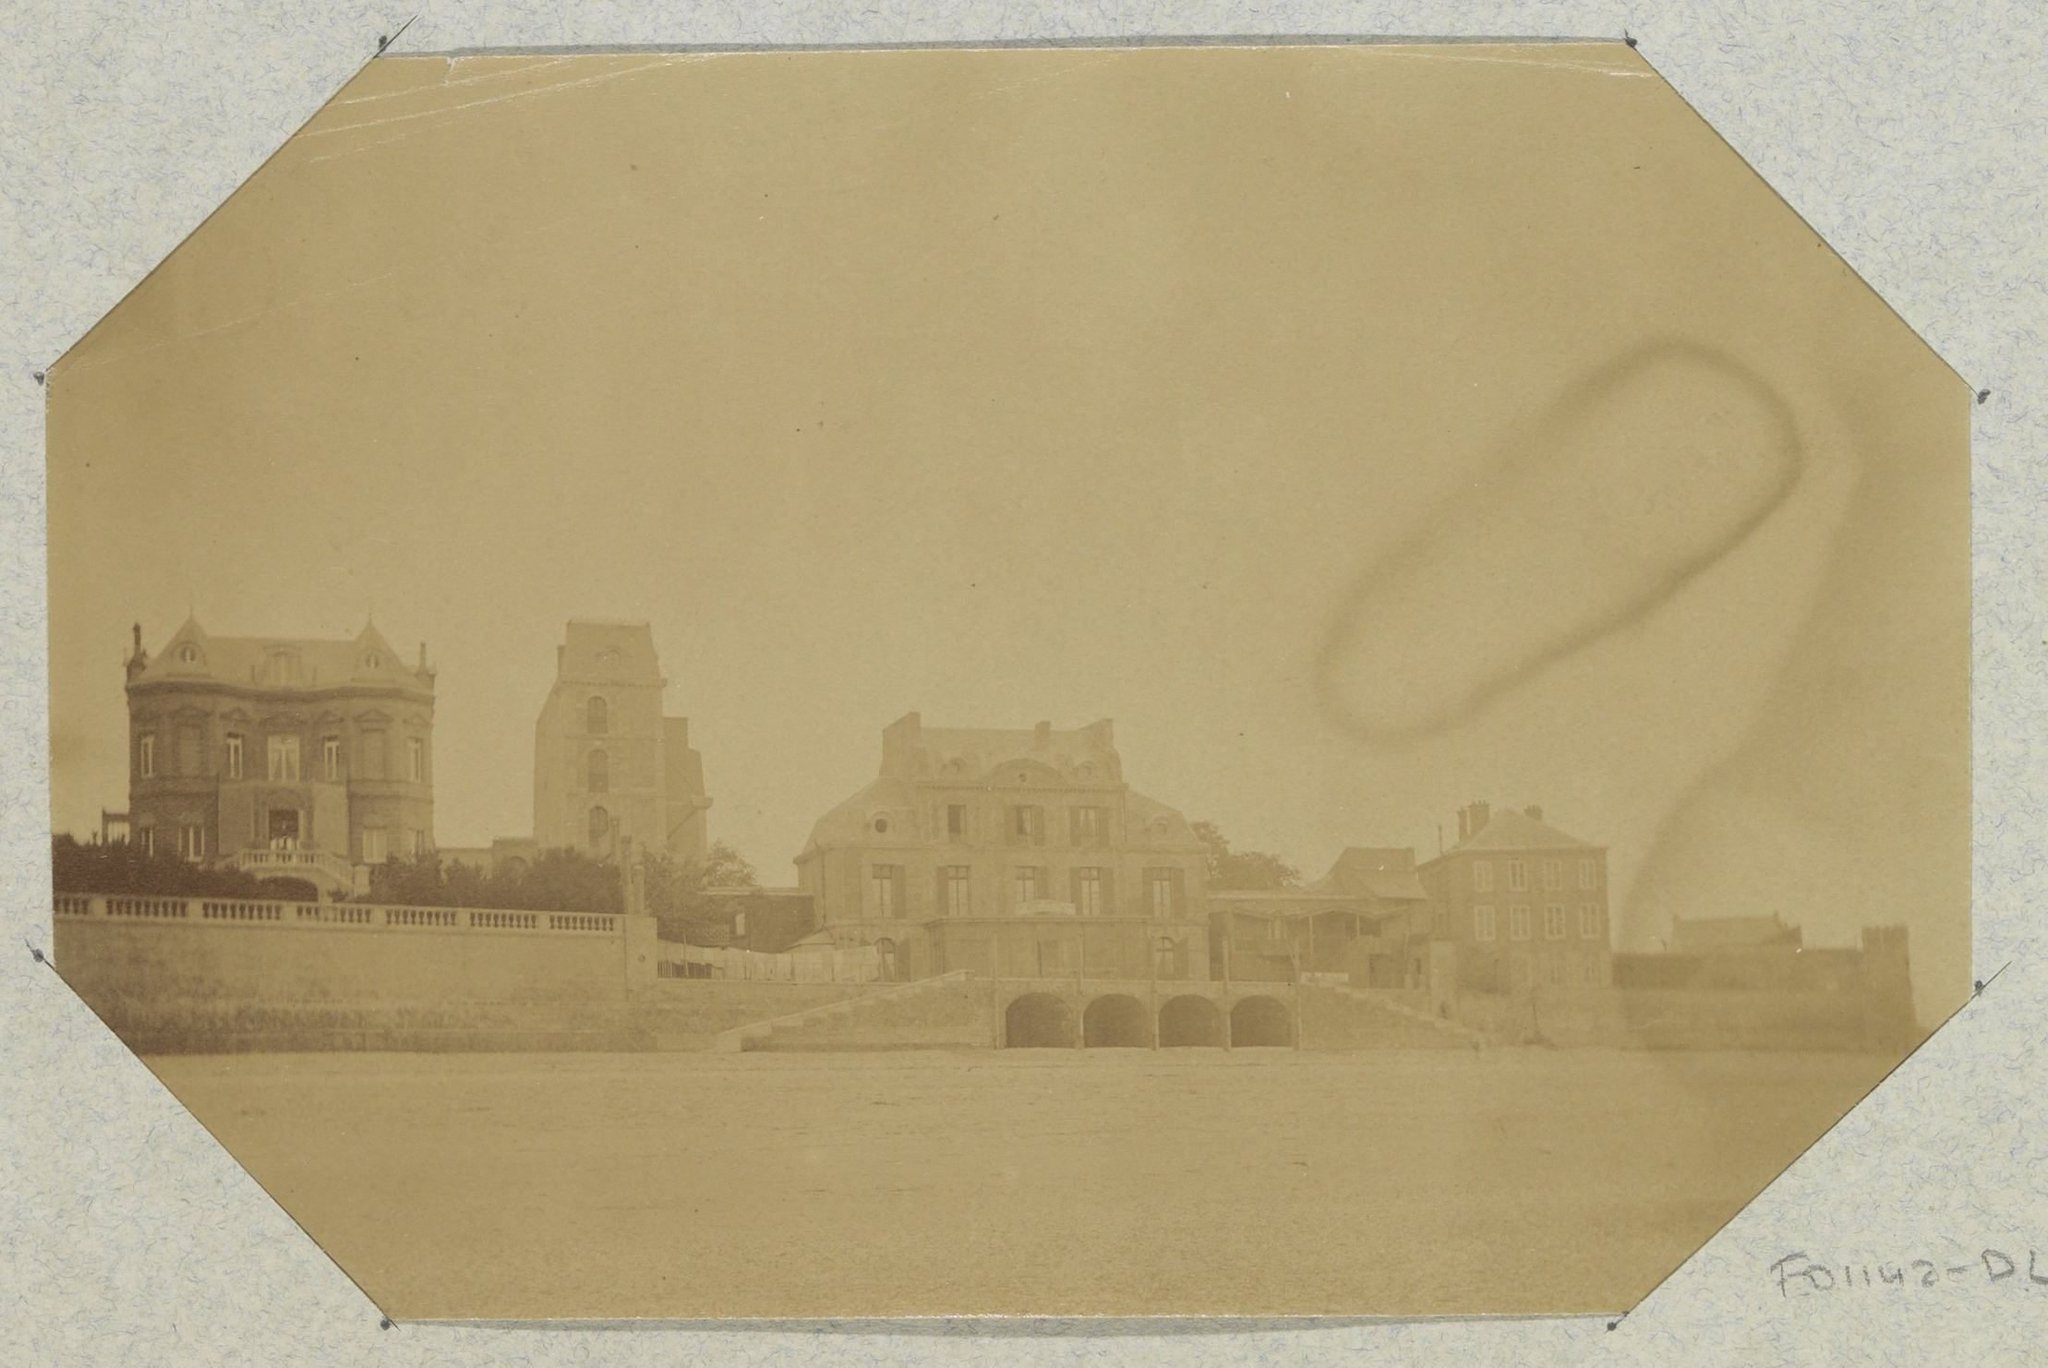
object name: photograph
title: Gezicht op villa's, mogelijk aan een kust of oever in Frankrijk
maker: Anonymous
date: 1880-1900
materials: paper, photographic support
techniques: albumen print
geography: france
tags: rural housing, e.g. country-house, villa, cottage, france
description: Onderdeel van Album van een Franse amateur met foto's van Frankrijk, Algerije, Palmyra, de Wereldtentoonstelling van 1900 en van bekende Fransen.